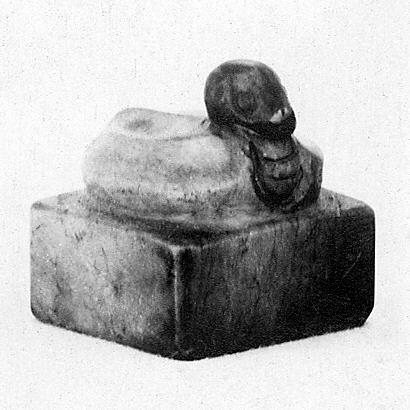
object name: seal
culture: chinese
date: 206 BCE-220 CE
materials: jade